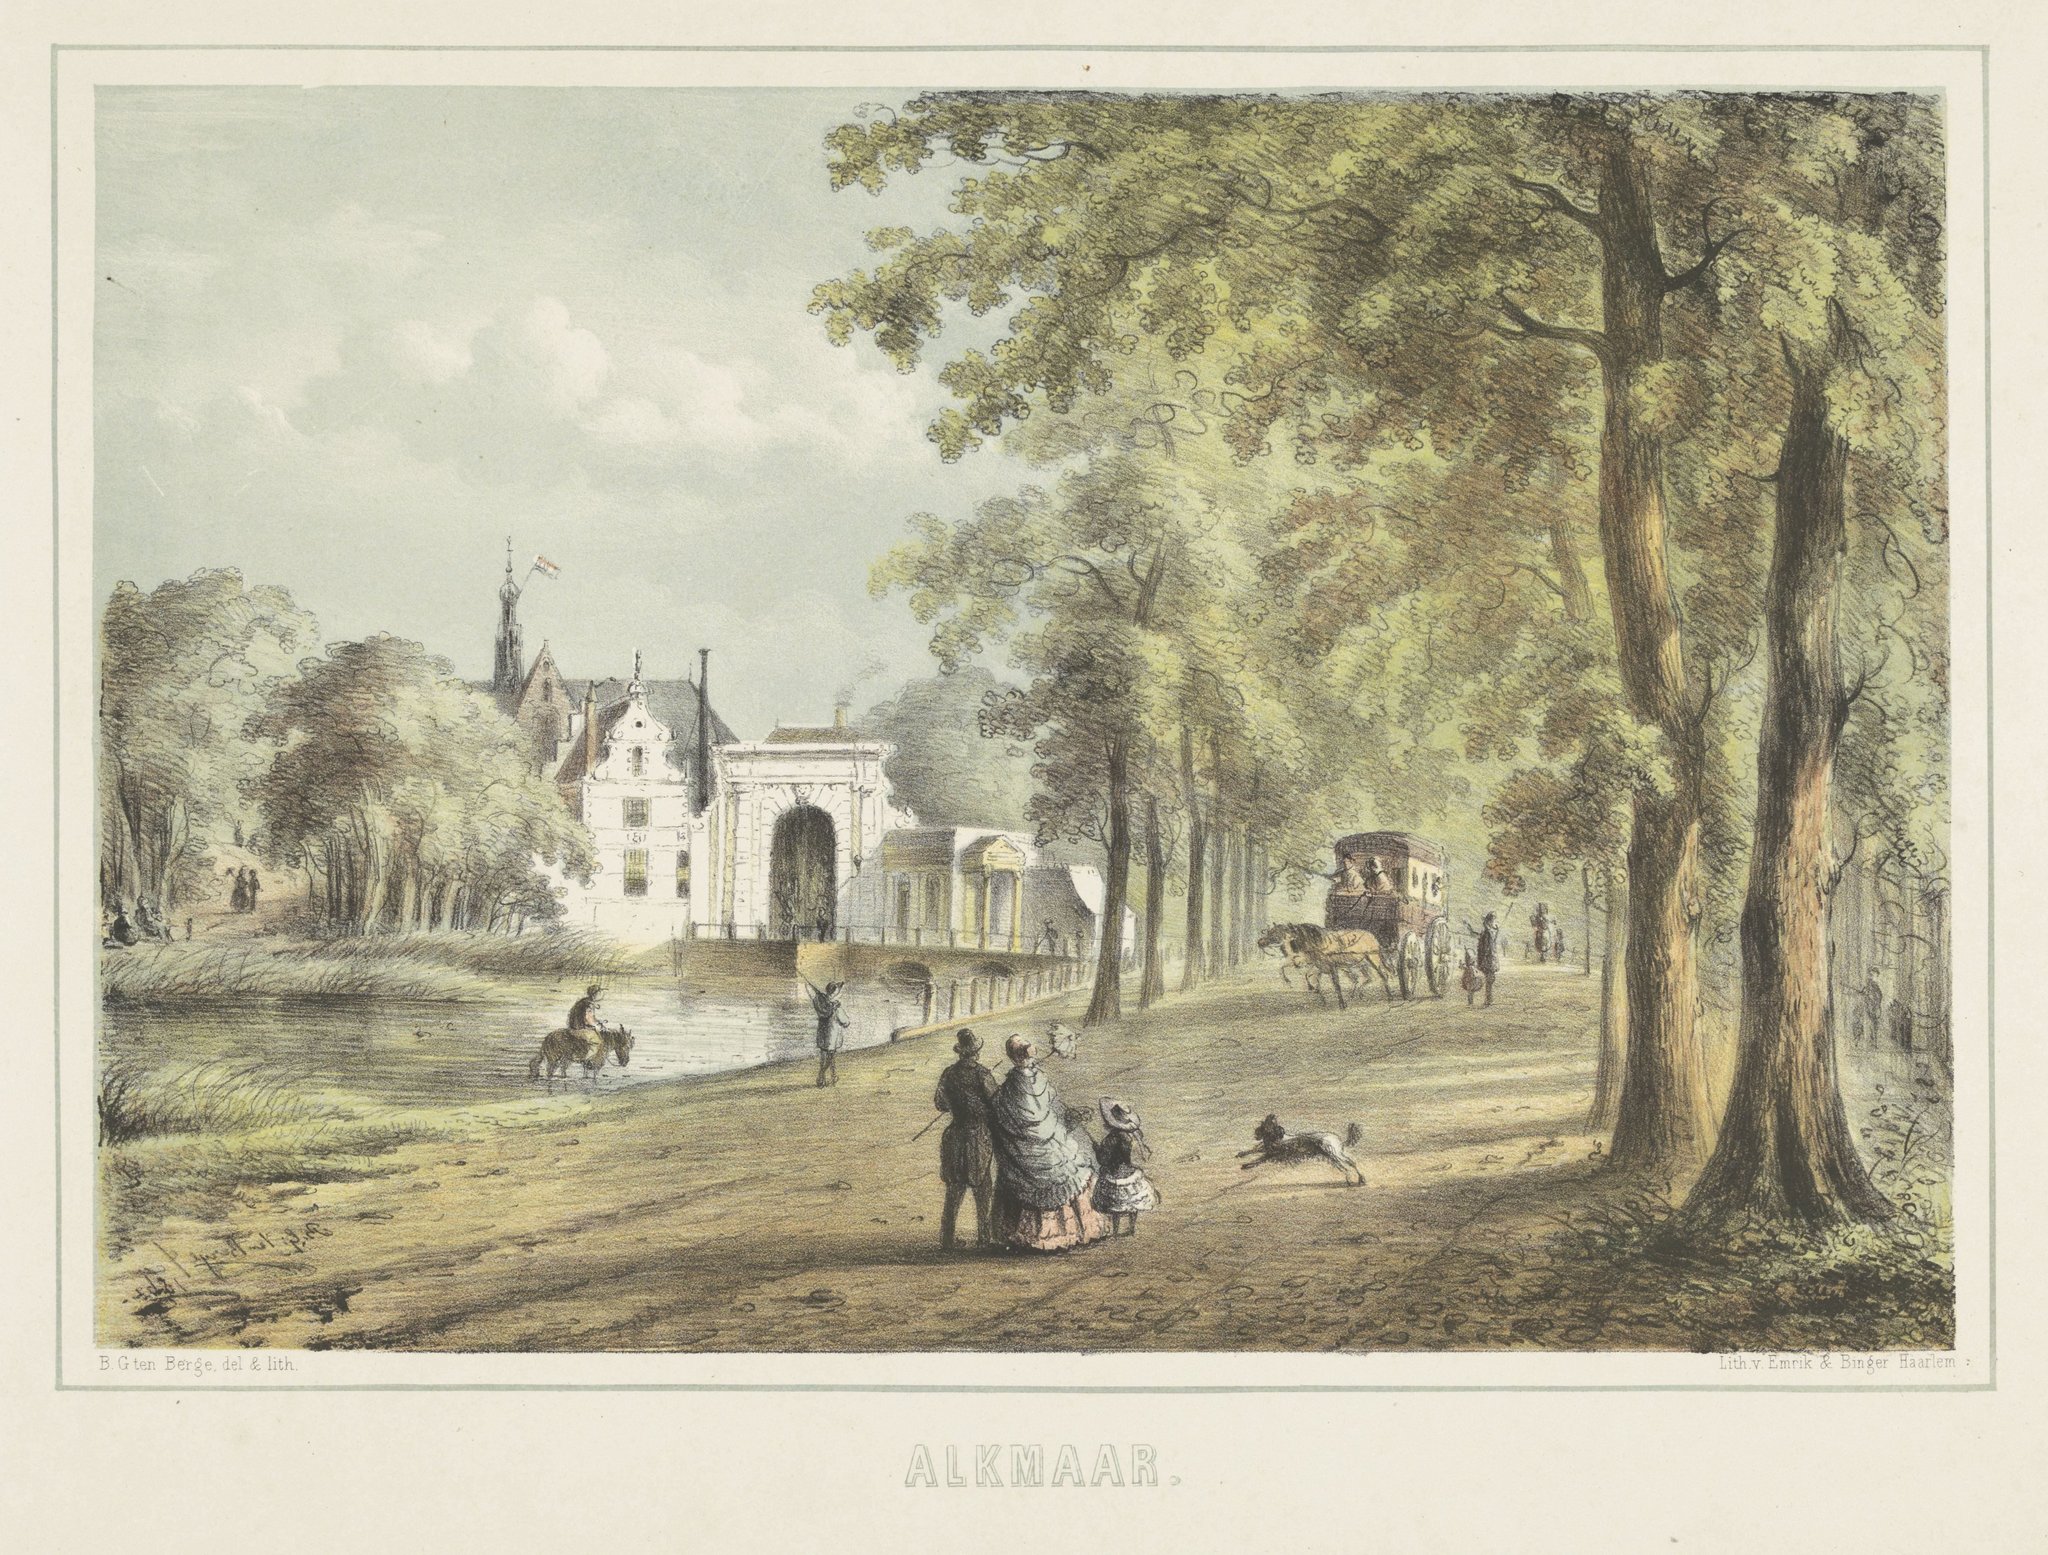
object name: print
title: Gezicht te Alkmaar met de Laurenskerk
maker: bernardus gerardus ten berge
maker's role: draughtsman, print maker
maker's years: 1835-1875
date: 1845-1875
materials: paper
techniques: lithograph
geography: alkmaar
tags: diligence, omnibus, horse-tram, city-view in general; 'veduta', avenue, boulevard, promenade, esplanade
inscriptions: collector's mark: Lugt 2228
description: Op het pad naast het water lopen verschillende figuren. Verderop komt een omnibus aanrijden. In het water staat een paard met ruiter.